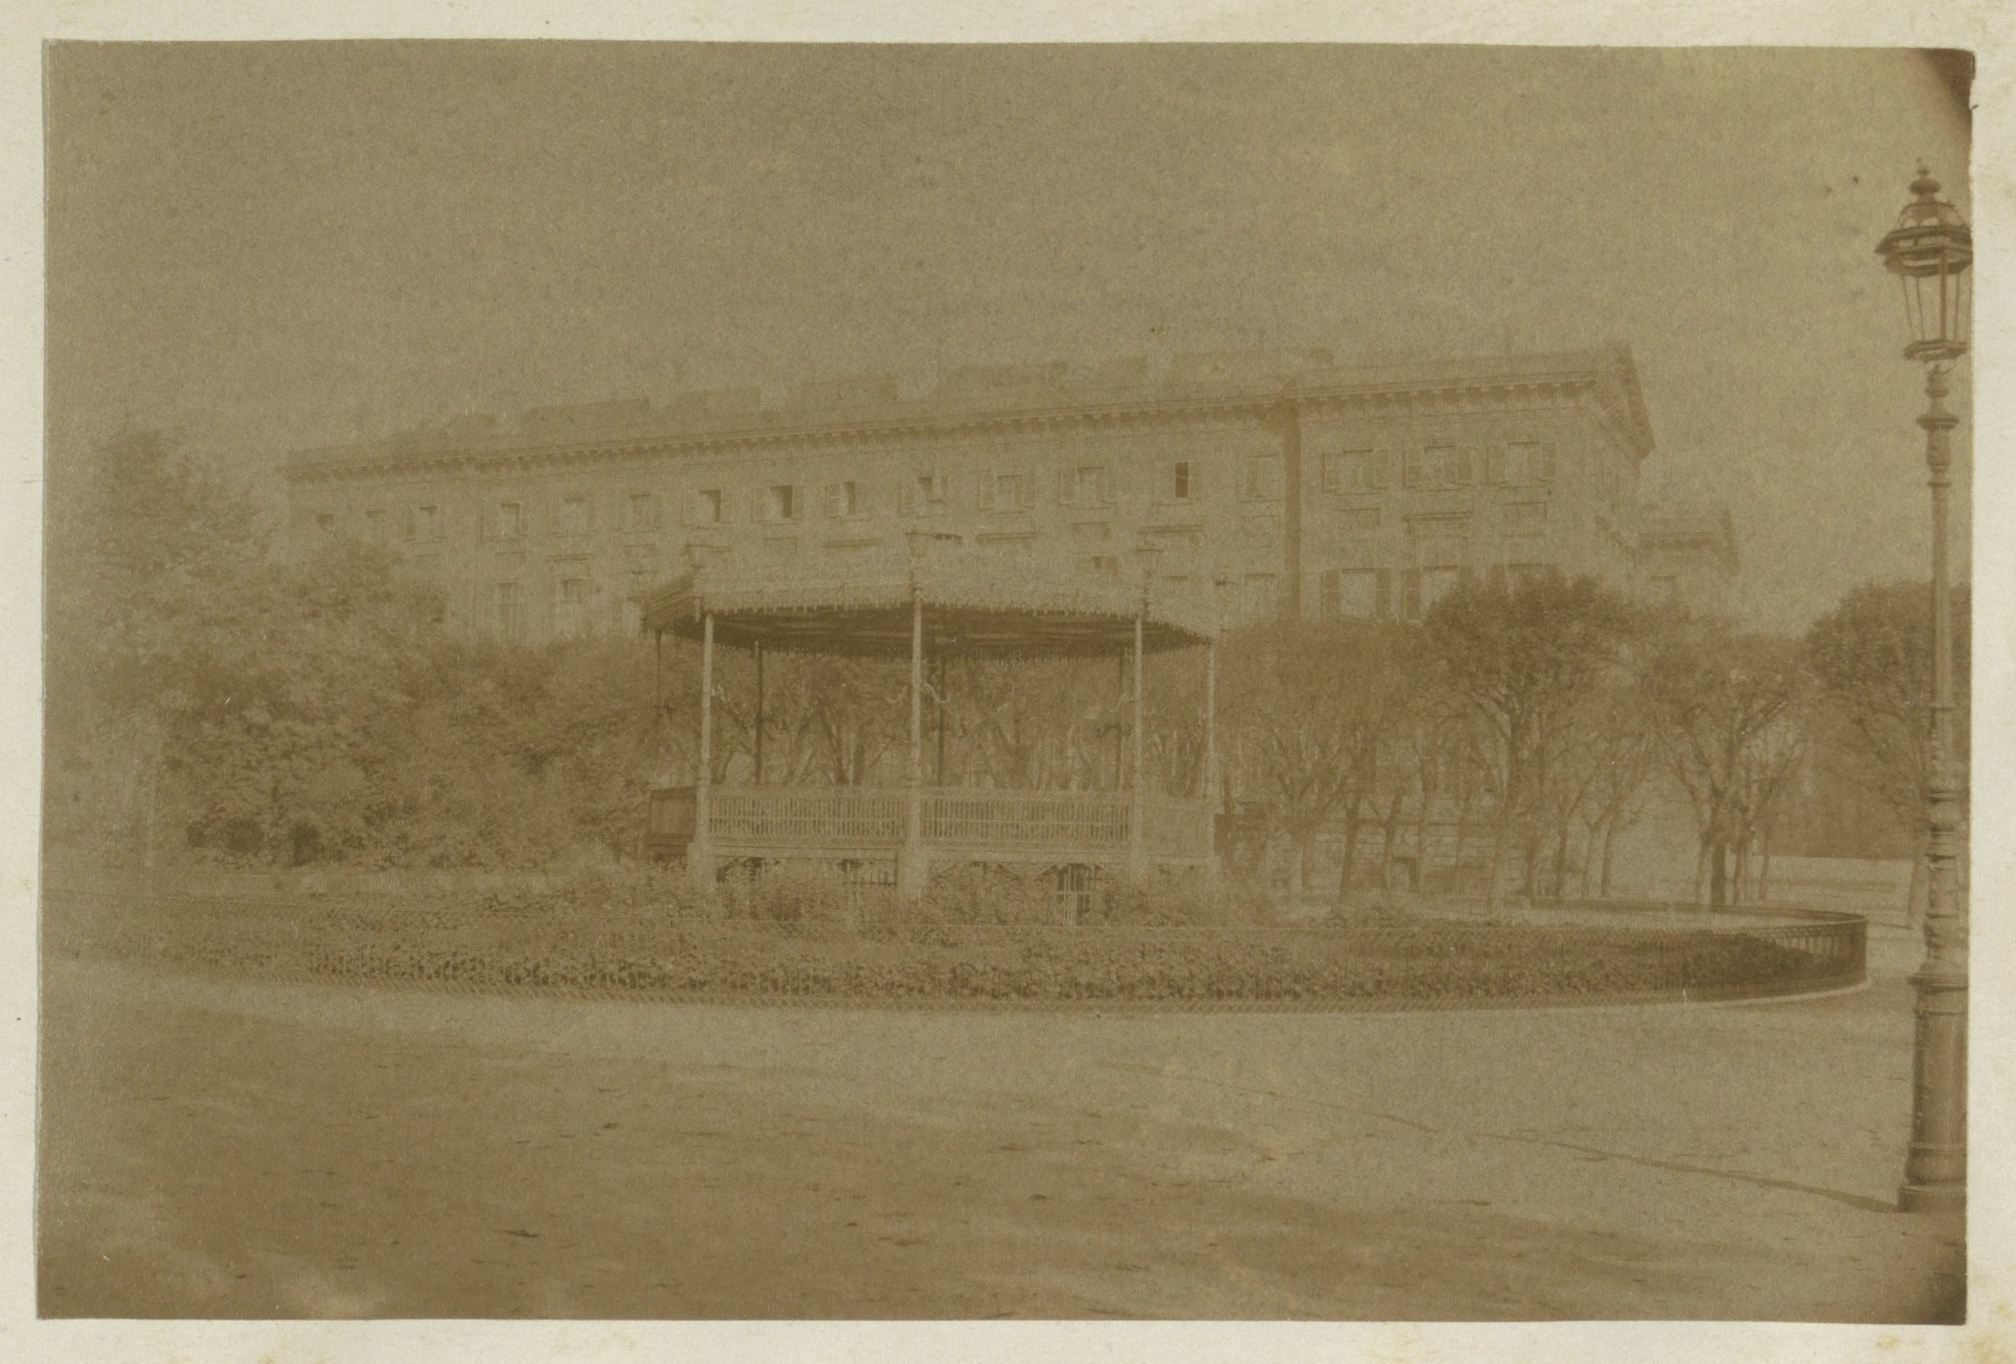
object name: photograph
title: Plantsoen met een muziektent, vermoedelijk in Frankrijk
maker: Anonymous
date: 1883-1886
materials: photographic support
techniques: albumen print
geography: france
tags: bandstand, france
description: Onderdeel van Album van een Franse amateurfotograaf met opnames van familie, militairen, industrie, landschappen en bezienswaardigheden in Frankrijk.